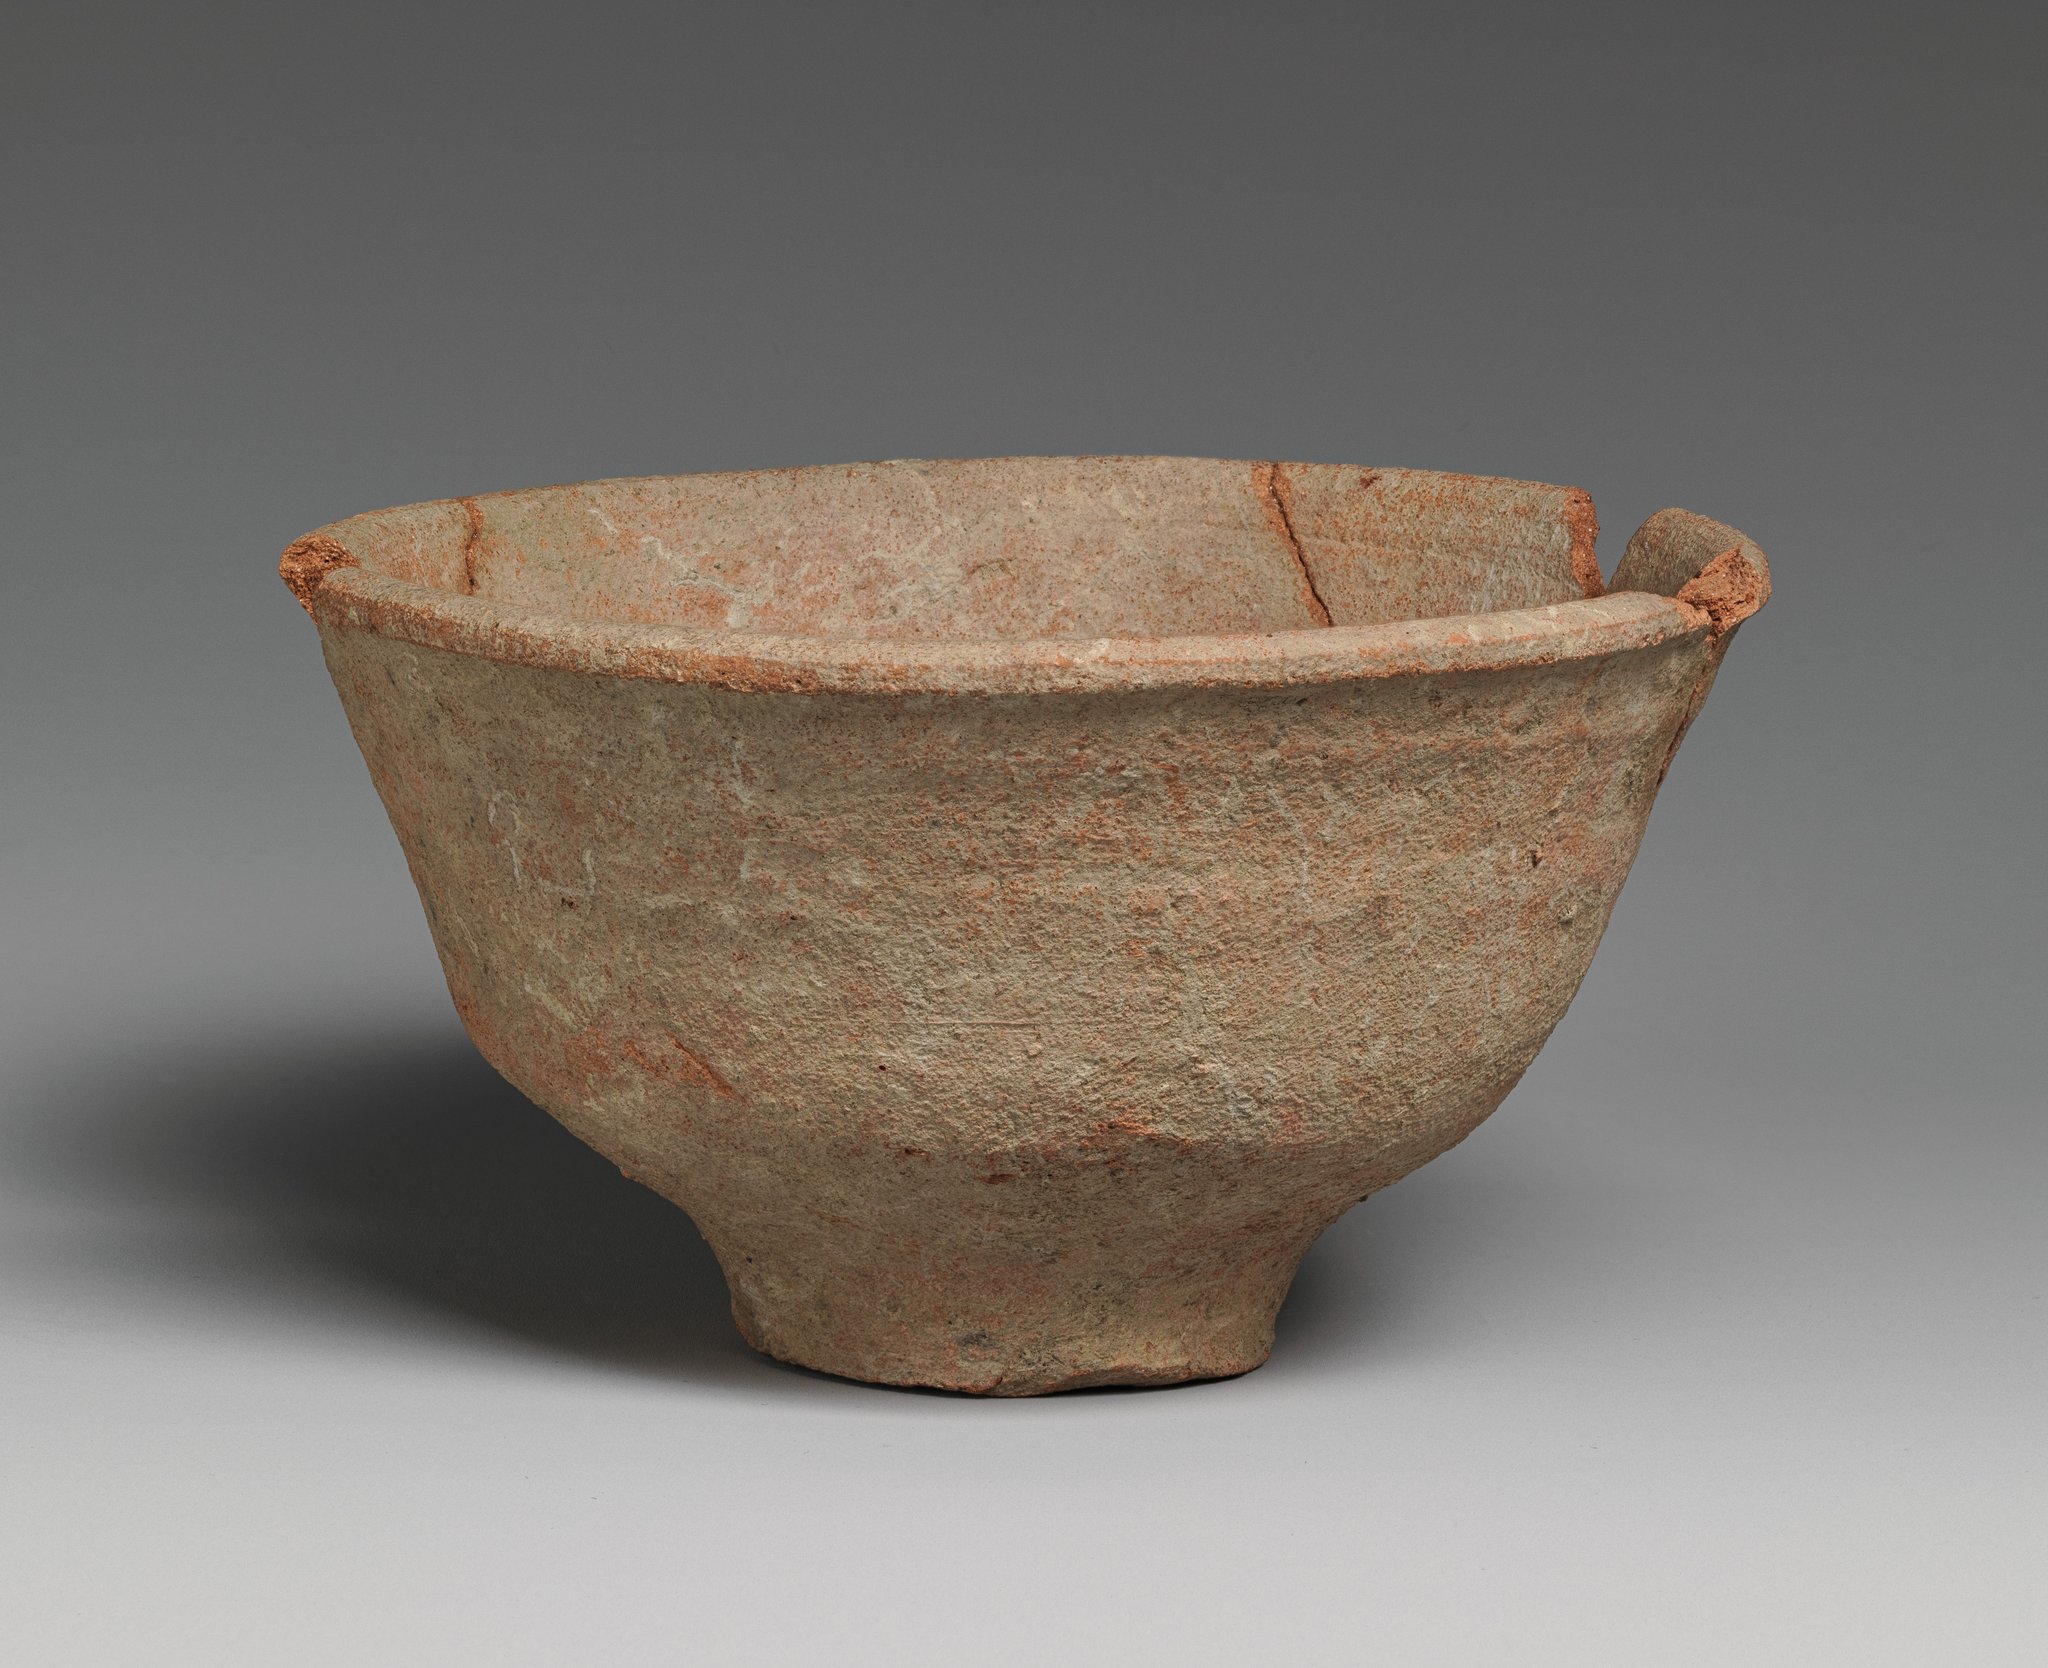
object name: bowl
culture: coptic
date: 400 BCE-400 CE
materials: earthenware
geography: egypt